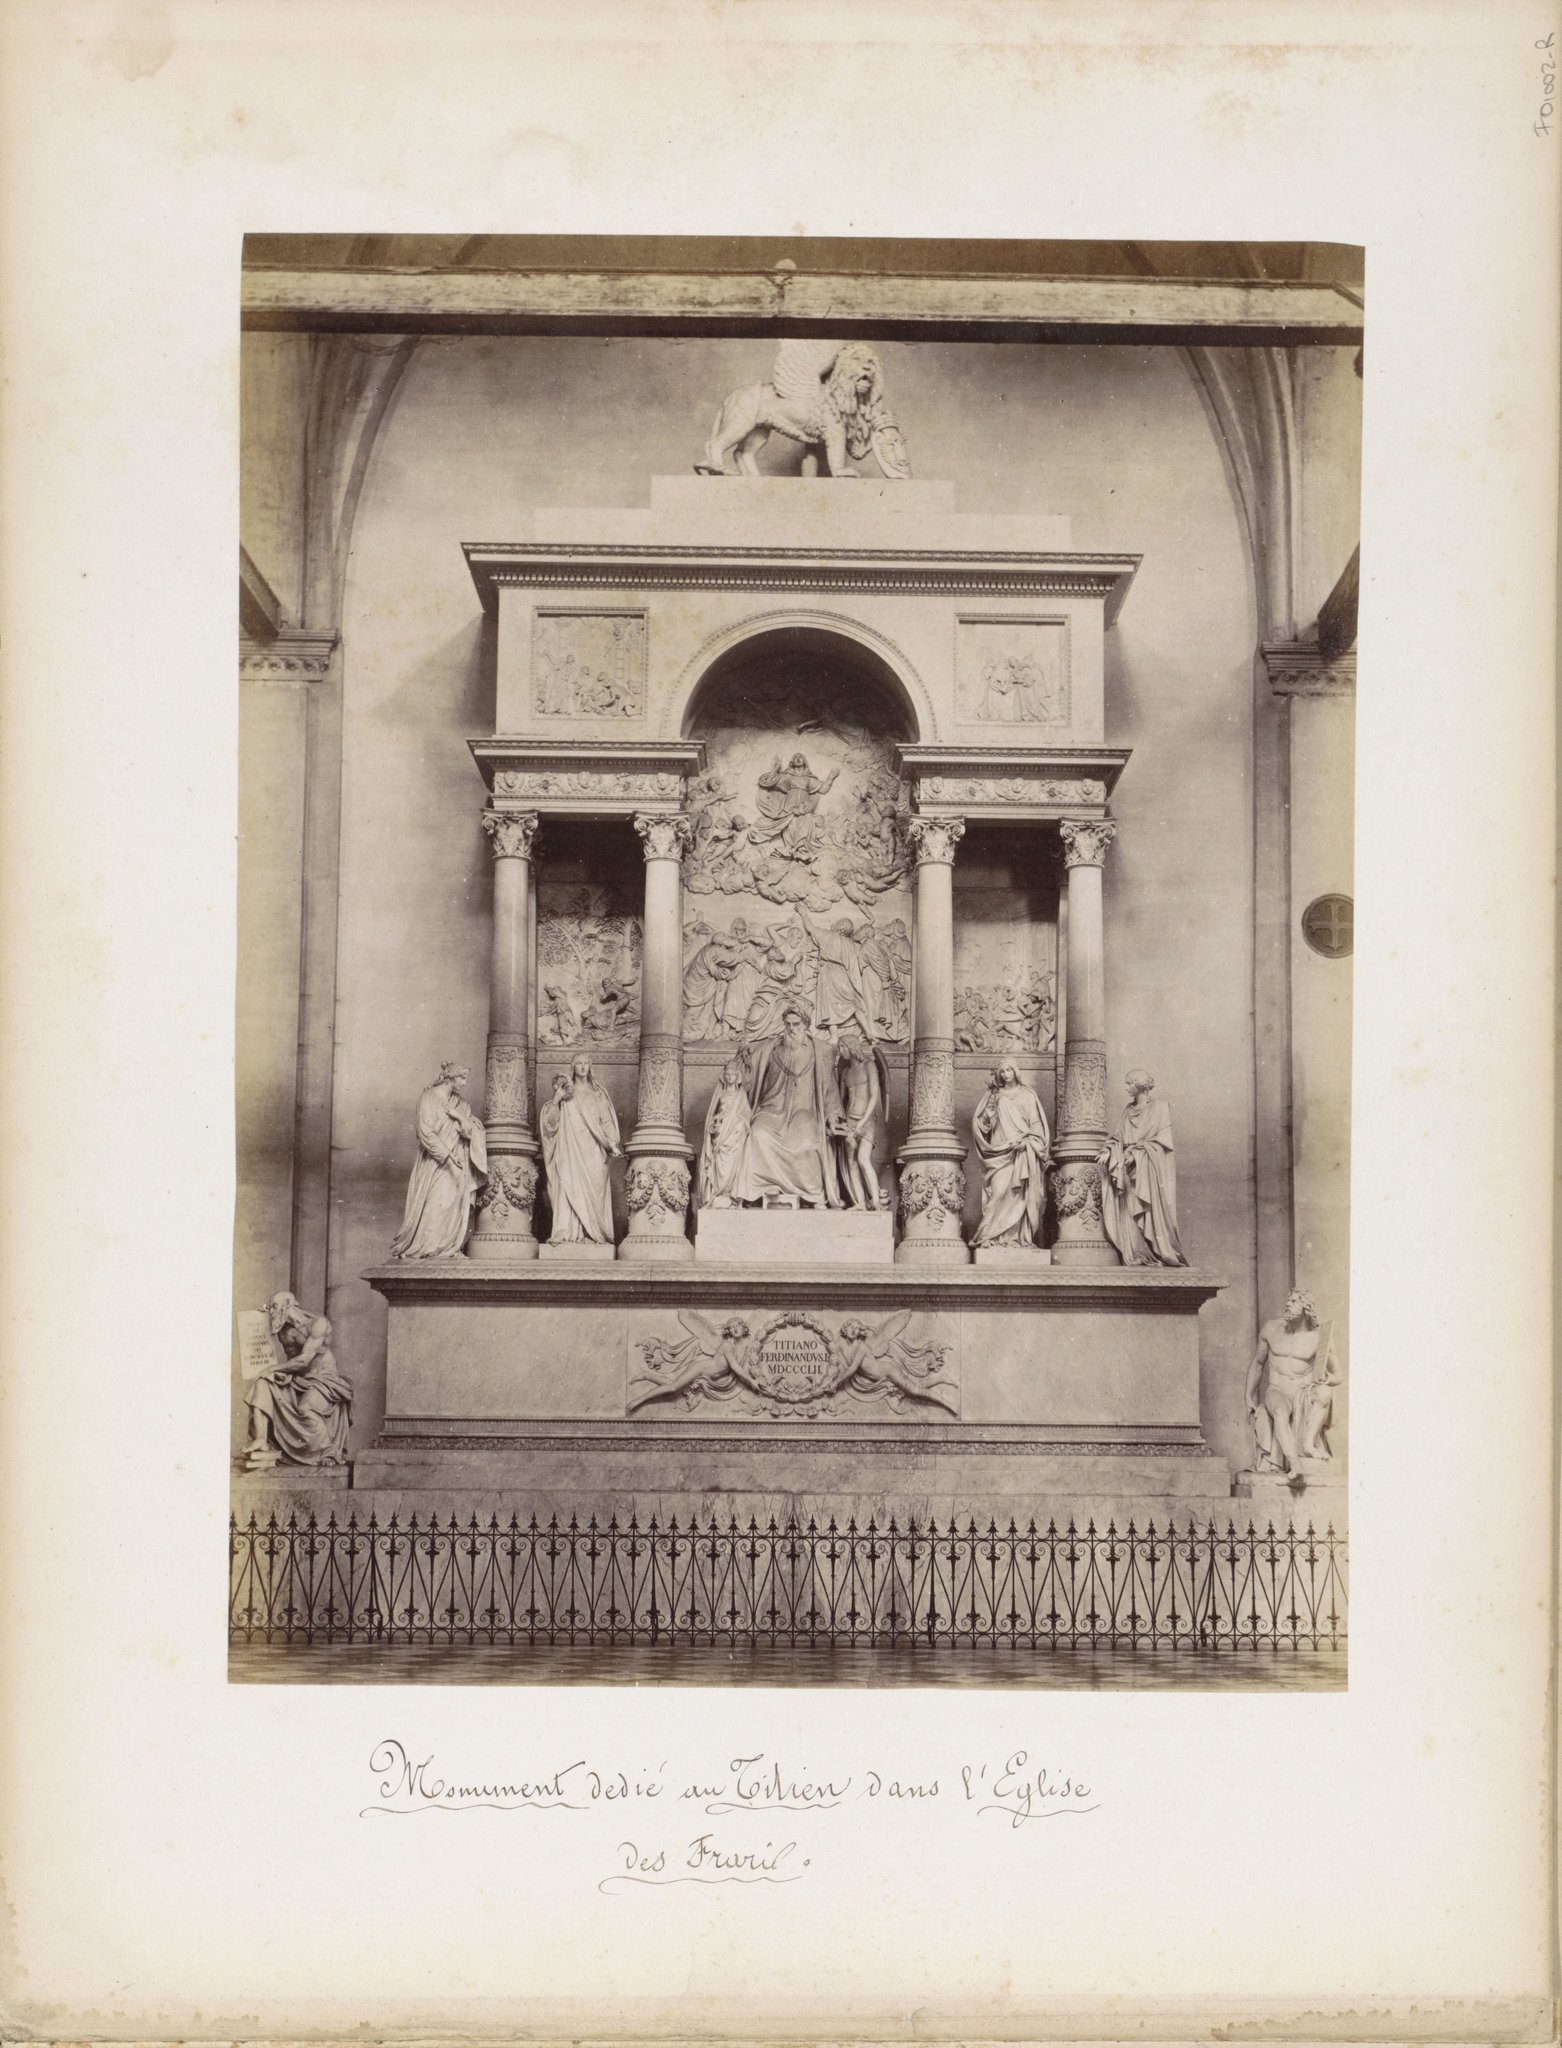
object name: photograph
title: Grafmonument van Titiaan in de Basilica di Santa Maria Gloriosa dei Frari in Venetië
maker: carlo ponti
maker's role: fotograaf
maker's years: 1820-1893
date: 1860-1881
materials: photographic support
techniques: albumen print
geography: venice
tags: monument, statue, grave-building, monumental tomb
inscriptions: check stamp: ‘Carlo Ponti Venezia’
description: Onderdeel van Topografisch album van Venetië 1881.